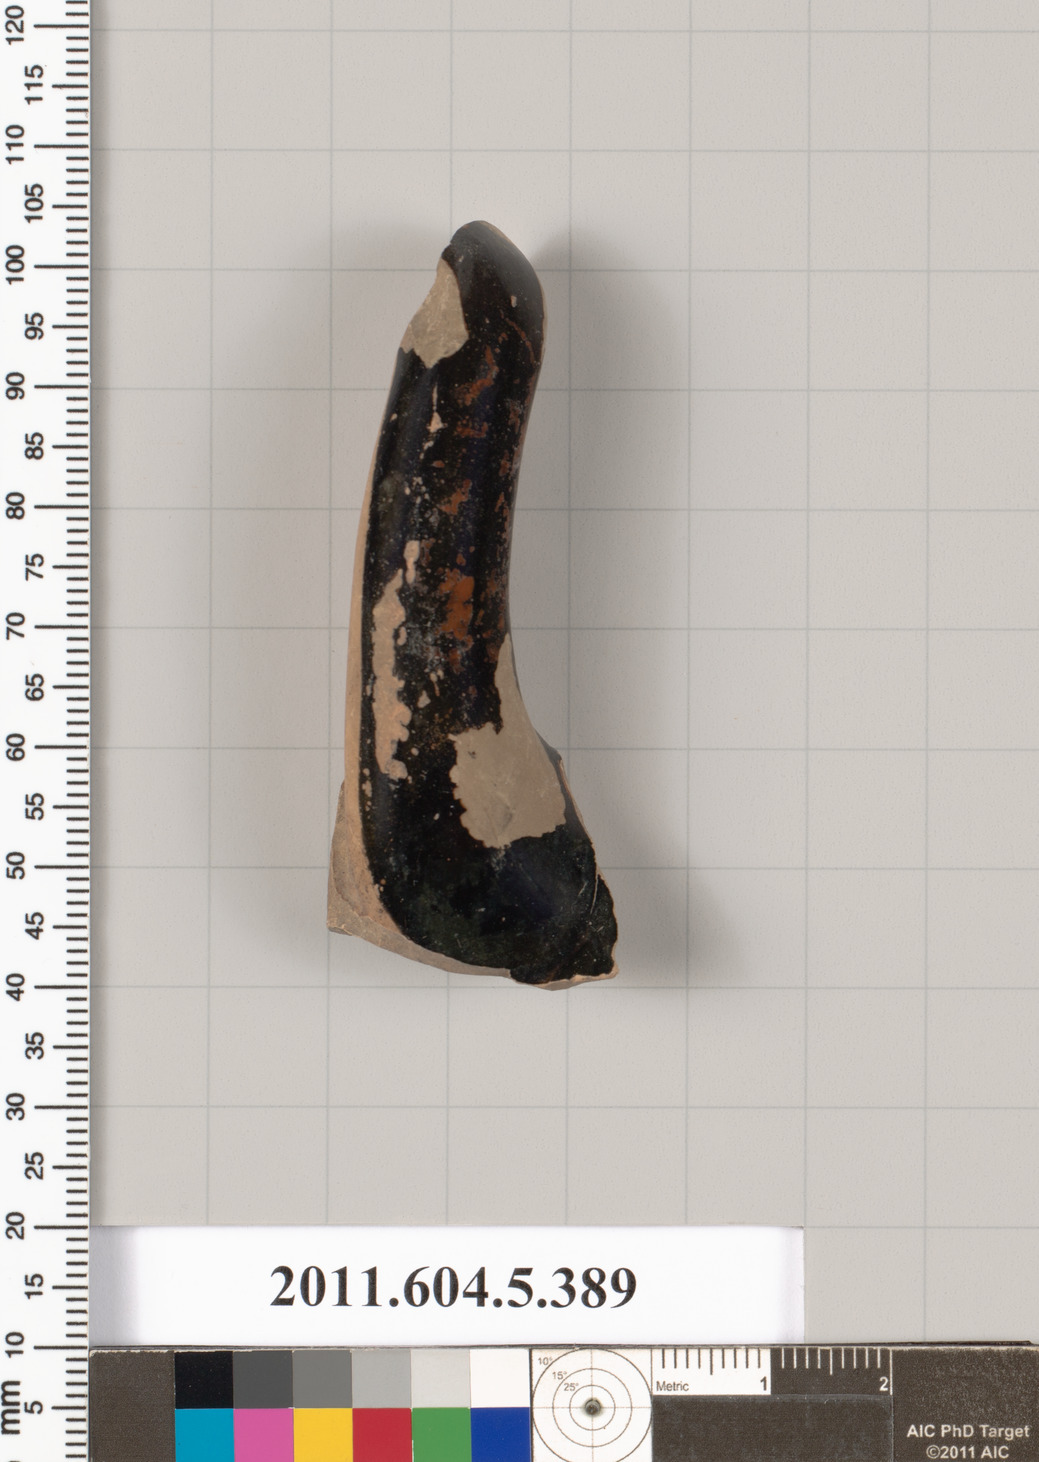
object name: kylix fragment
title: Terracotta fragment of a kylix (drinking cup)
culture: greek, attic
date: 600-401 BCE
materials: terracotta